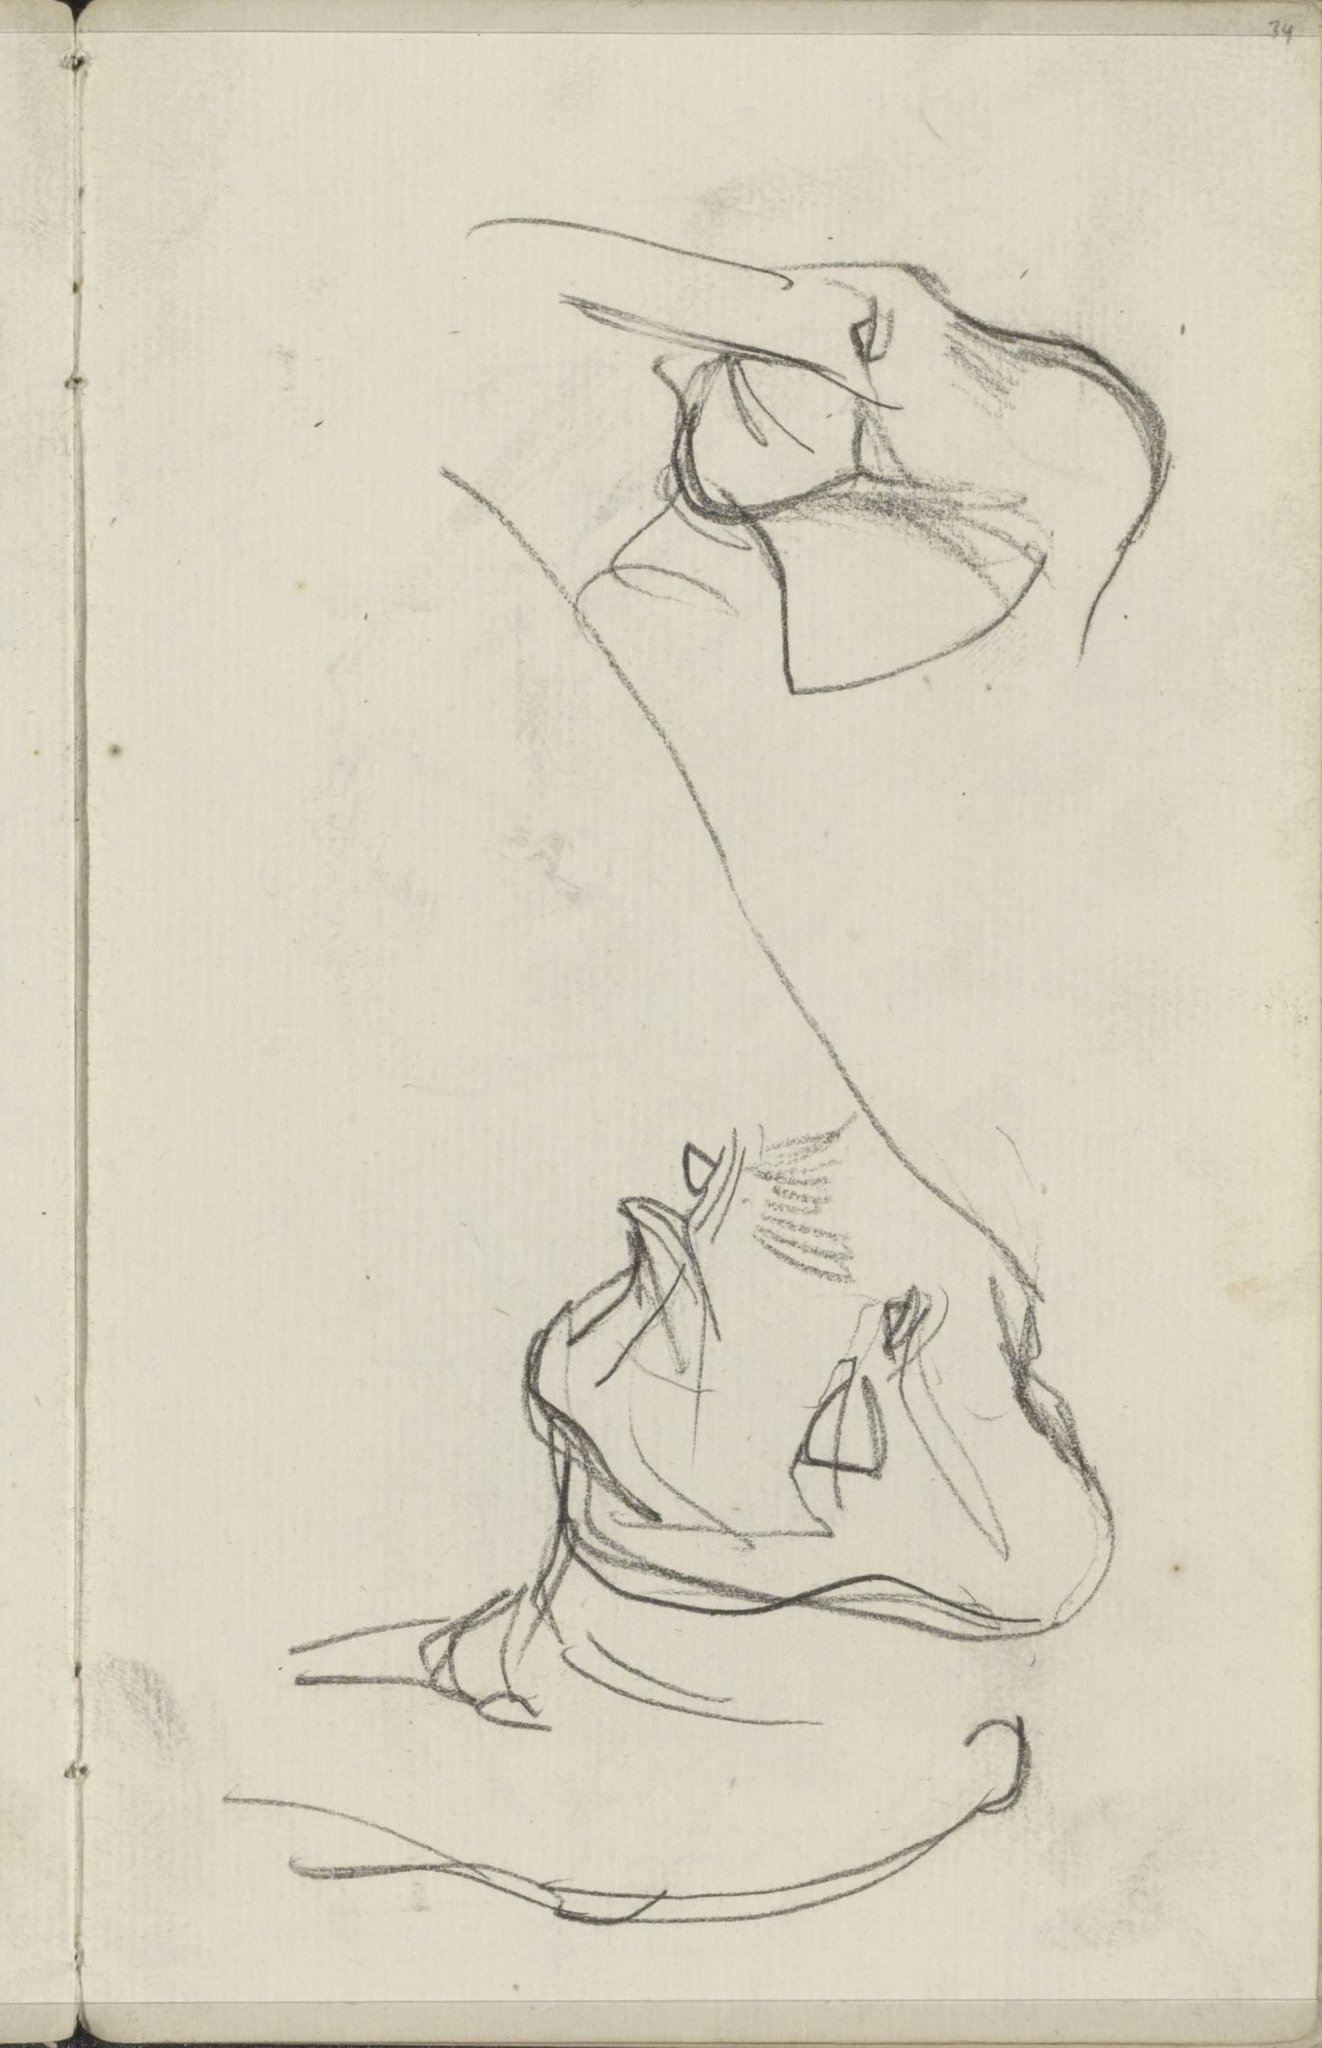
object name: sketchbook leaf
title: Twee olifanten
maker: george hendrik breitner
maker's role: draughtsman, painter, print maker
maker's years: 1857-1923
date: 1884-1886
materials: chalk, paper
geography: paris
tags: trunked animals: elephant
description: Pagina 34 uit een schetsboek met 25 bladen.